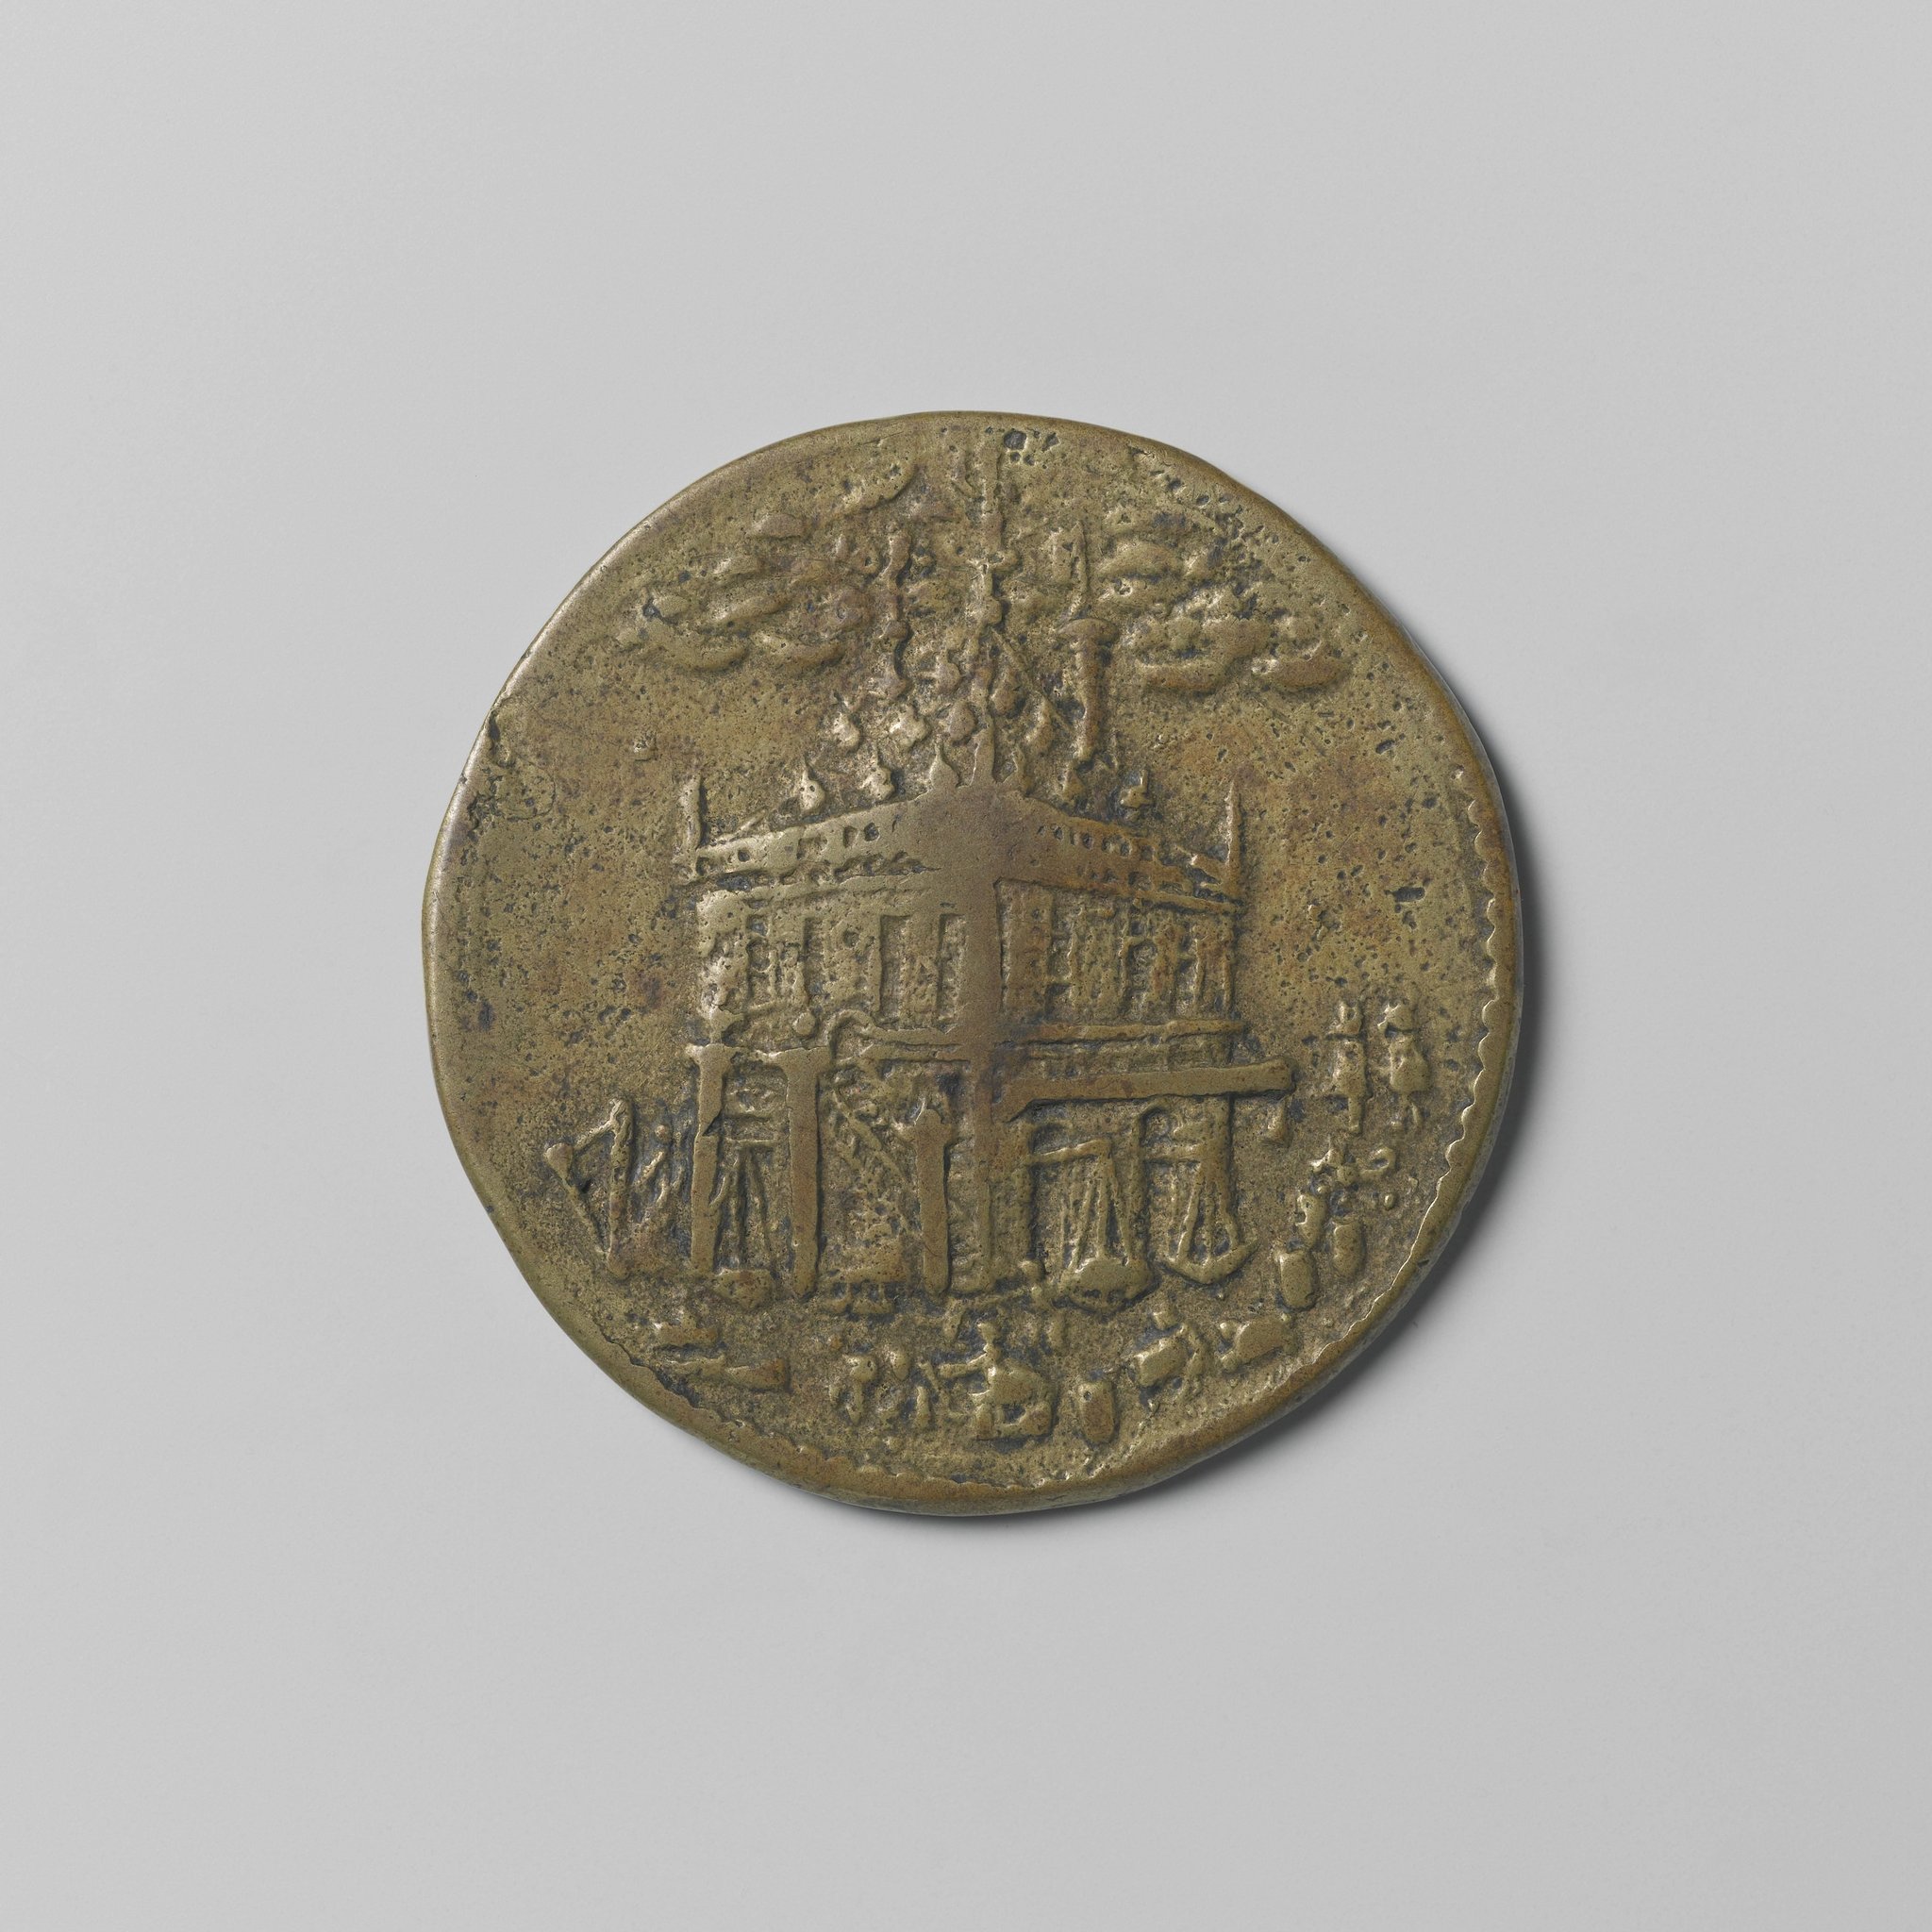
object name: funeral token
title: Waagdragersgilde van Amsterdam, begrafenispenning met no. 108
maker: hans rogiers van harelbeke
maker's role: metalworkers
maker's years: -1638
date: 1618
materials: brass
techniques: casting, engraving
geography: amsterdam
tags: amsterdam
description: Messing penning. Voorzijde: gezicht op Waaggebouw te Amsterdam. Keerzijde: onder jaartal: gekroond wapenschild, geflankeerd door twee leeuwen binnen palmkrans; afsnede: cijfer 108